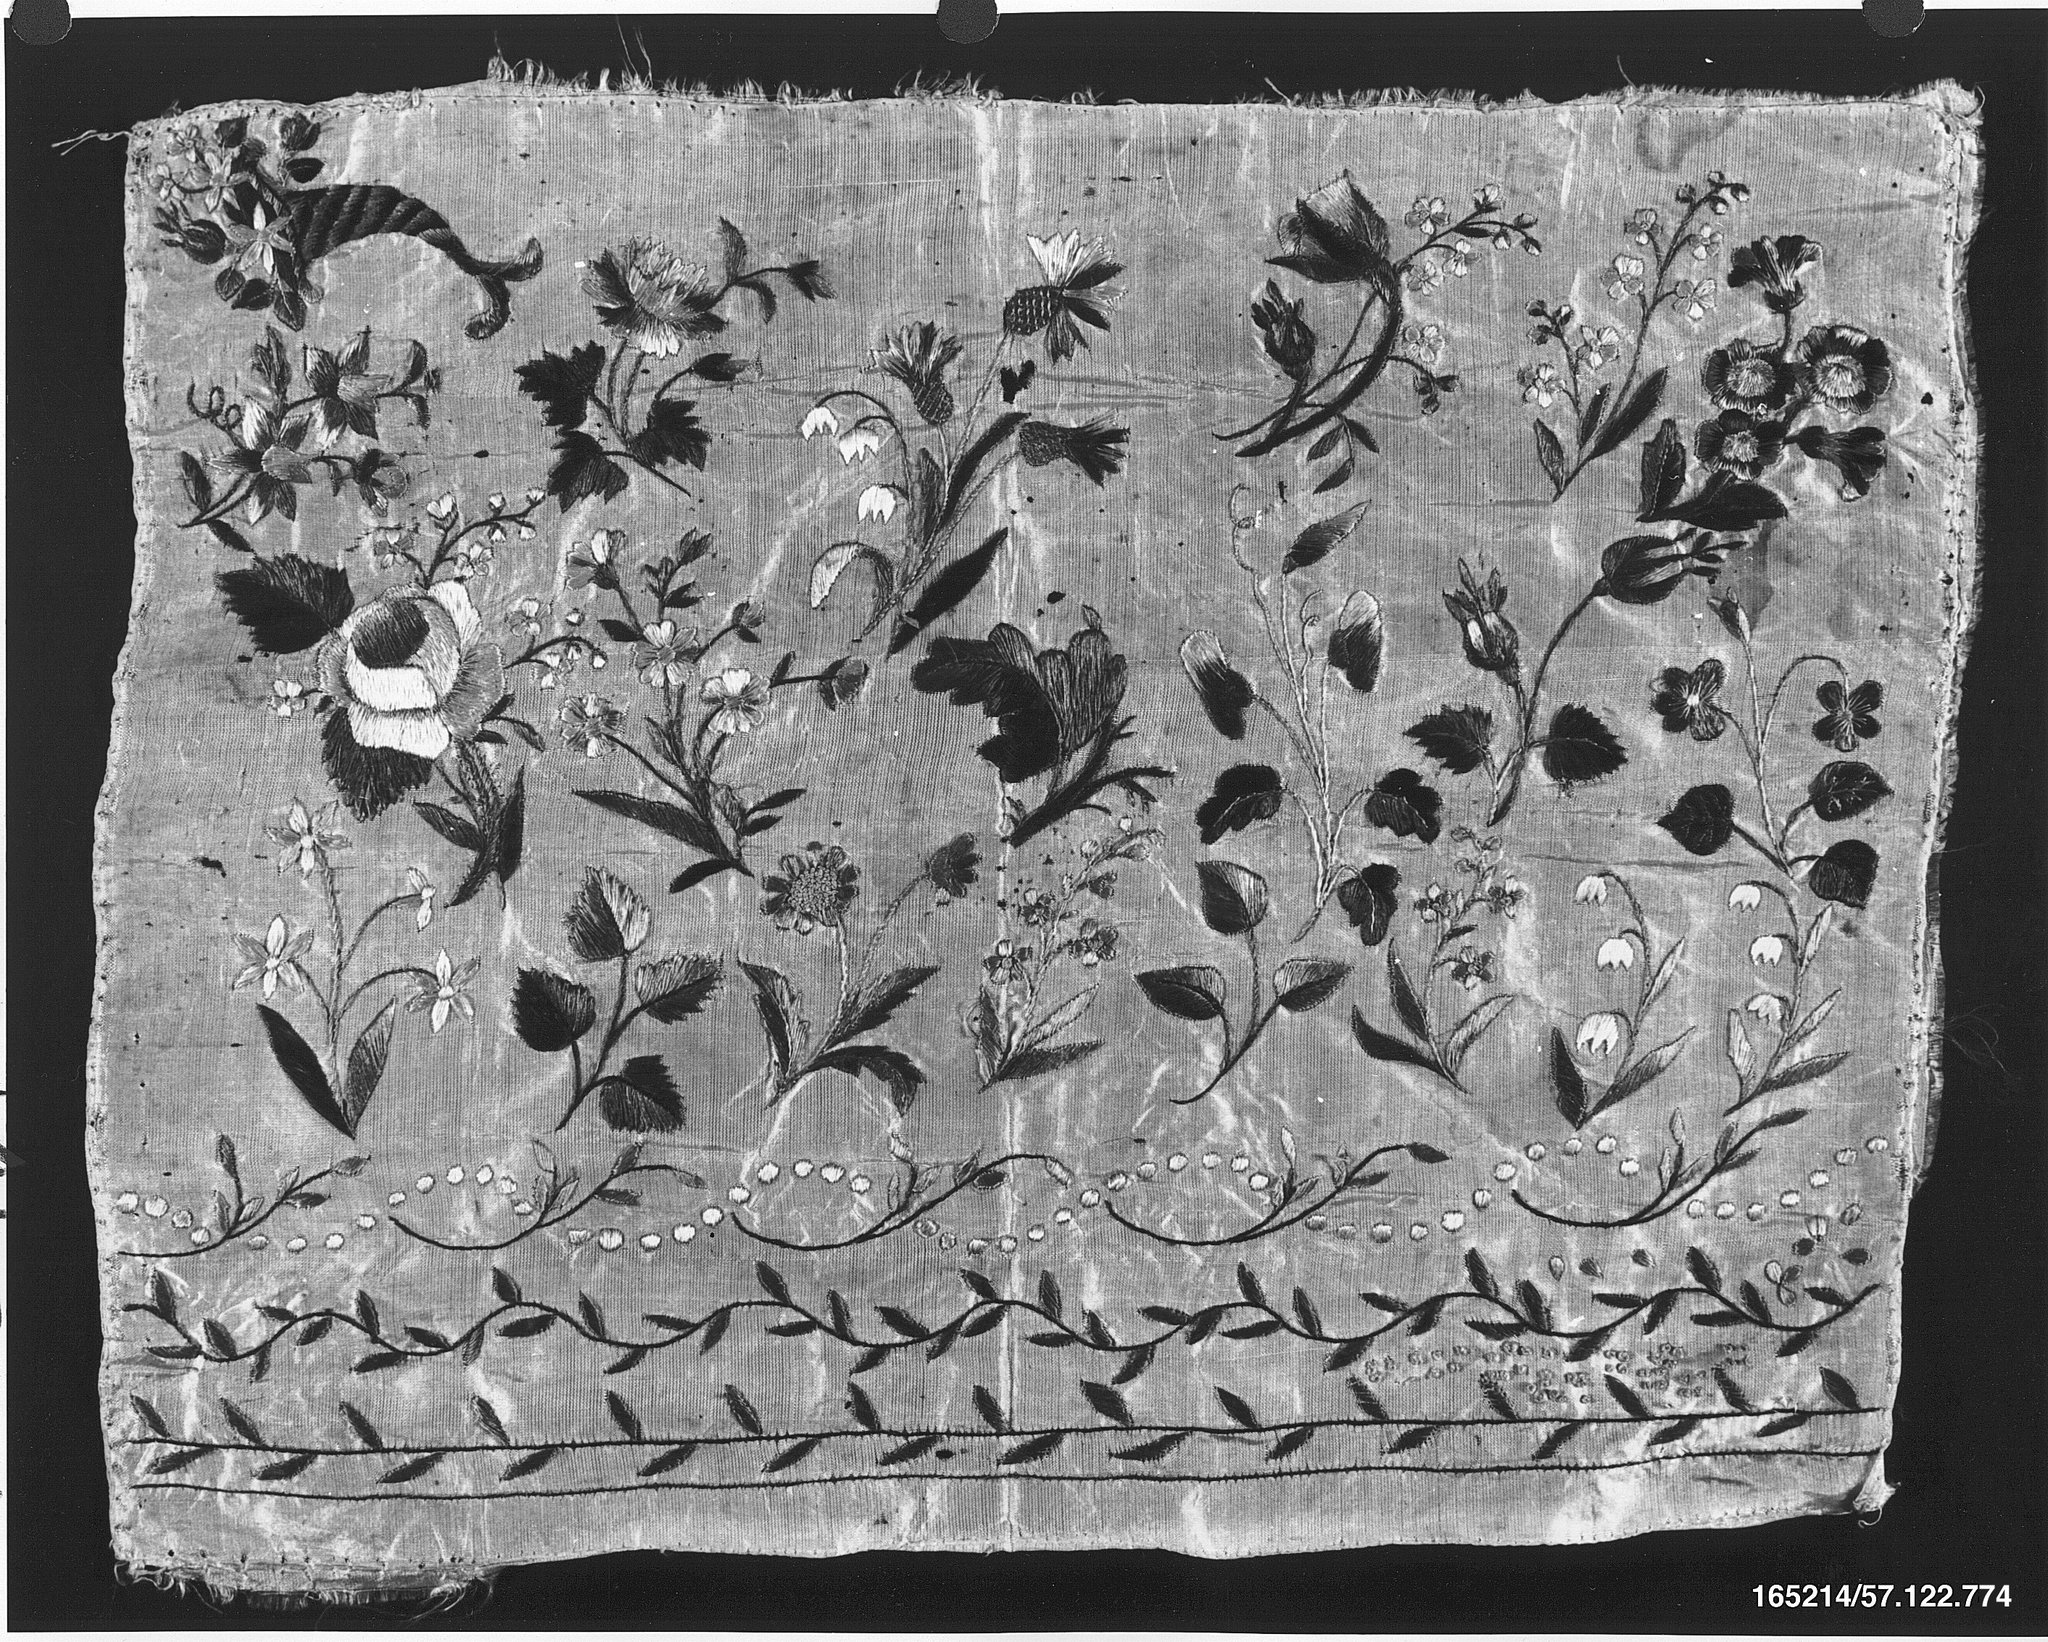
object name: sampler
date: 1801-1900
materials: silk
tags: flowers,leaves